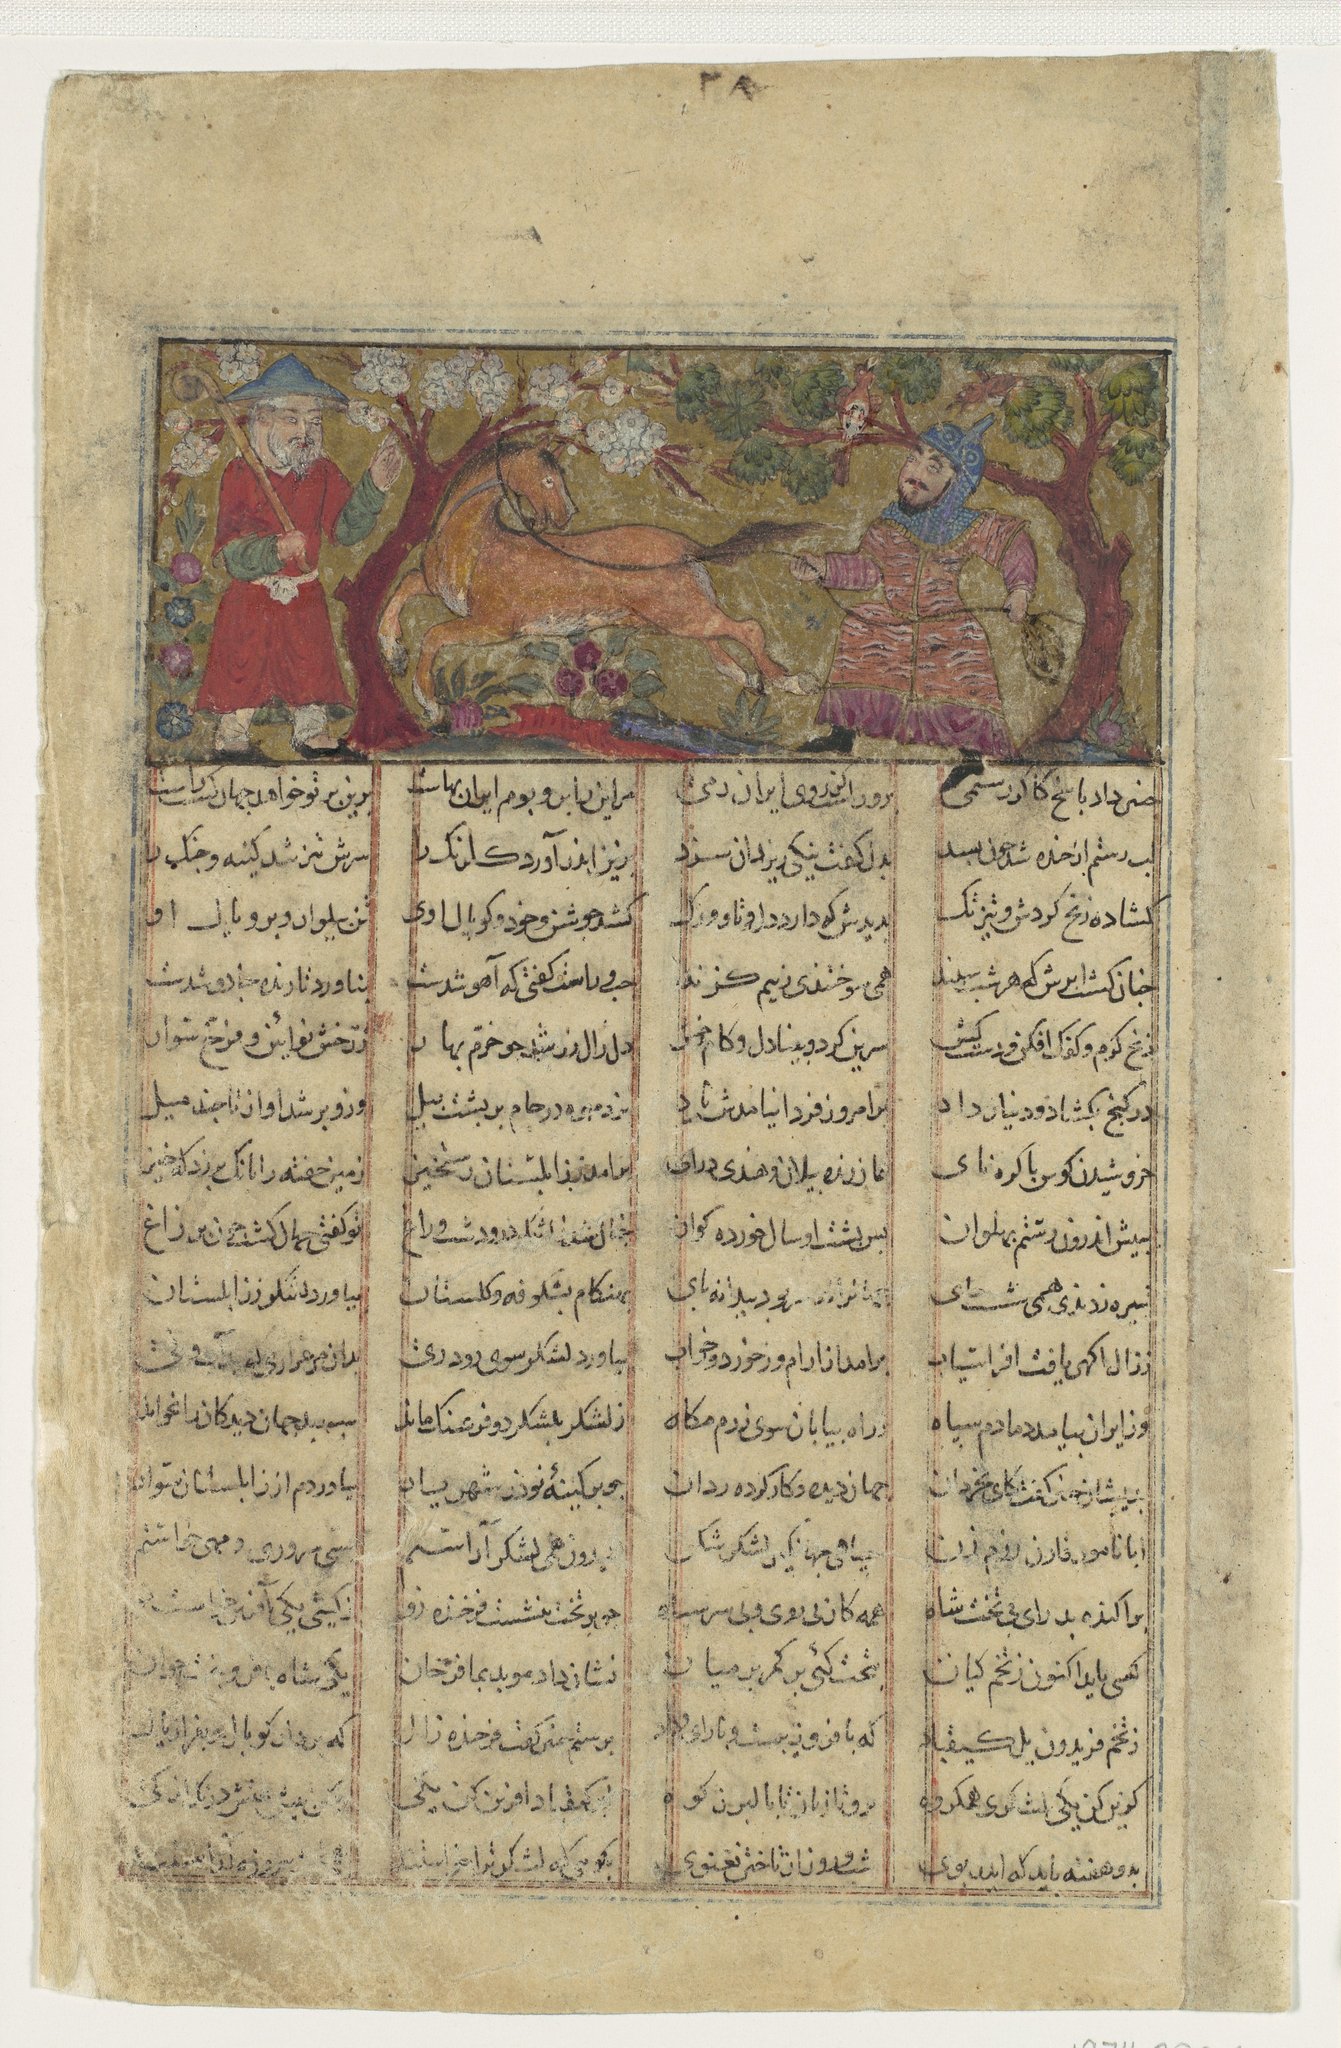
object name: folio from an illustrated manuscript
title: "Rustam Lassos Rakhsh," Folio from a Shahnama (Book of Kings) of Firdausi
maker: abu'l qasim firdausi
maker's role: author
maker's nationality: iranian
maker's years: 935-1020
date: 1330-1340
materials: gold, ink, paper, silver, watercolor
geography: iran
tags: men,horses,trees